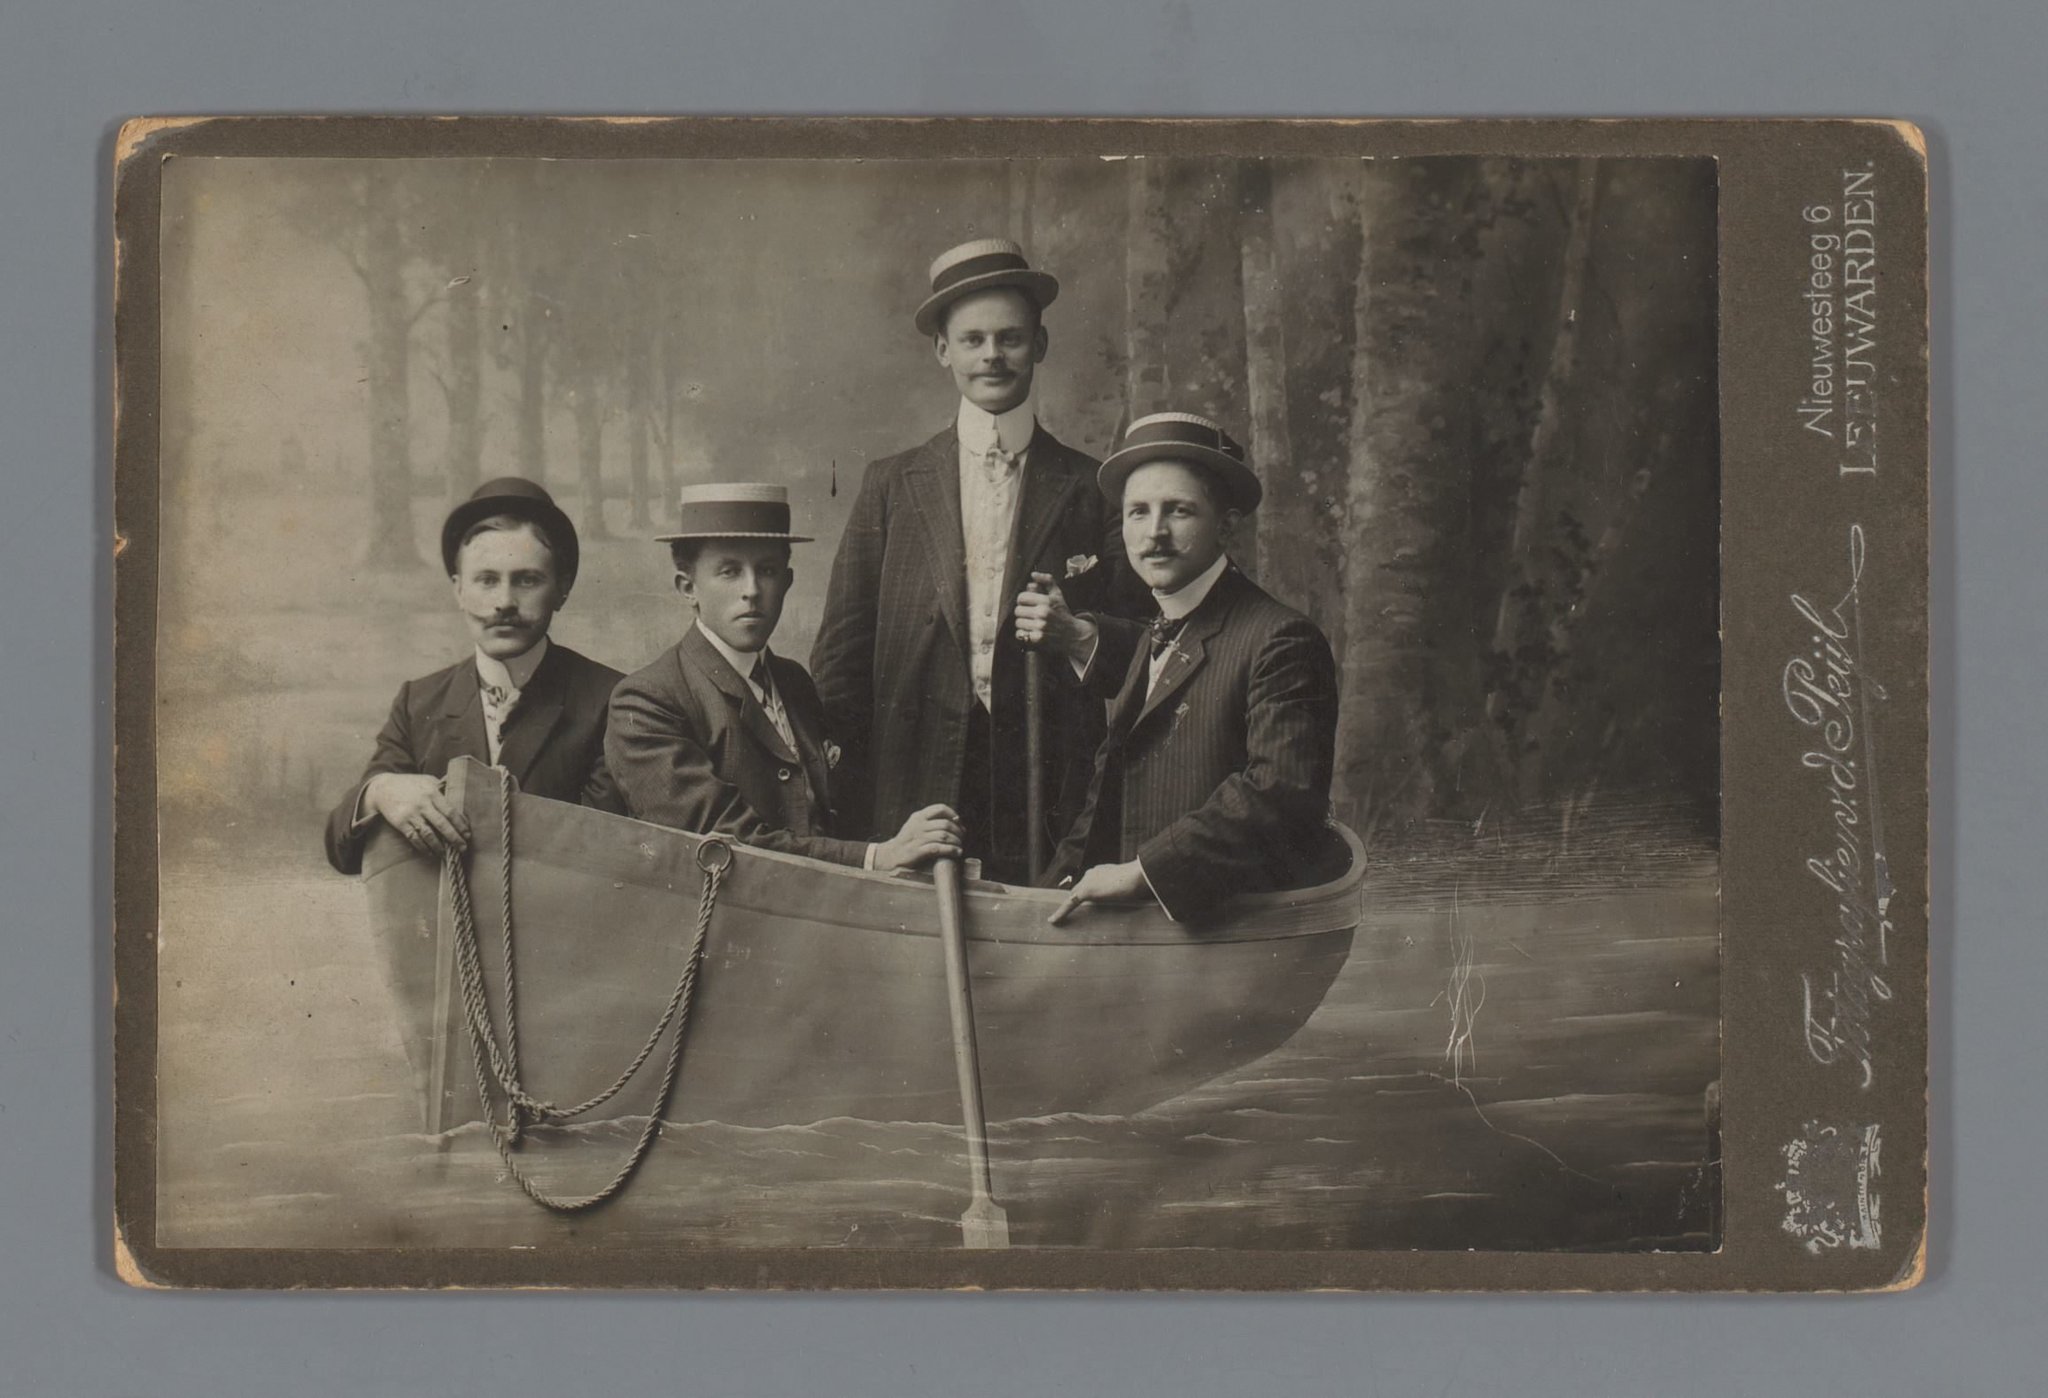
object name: photograph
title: Studioportret van een vier mannen in een roeiboot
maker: jacobus marinus van der peijl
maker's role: fotograaf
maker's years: 1883-1947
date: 1905-1915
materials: cardboard, paper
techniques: carbon print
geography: leeuwarden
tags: studio ~ photographer, rowing-boat, canoe, etc., anonymous historical persons portrayed in a group, in a group-portrait